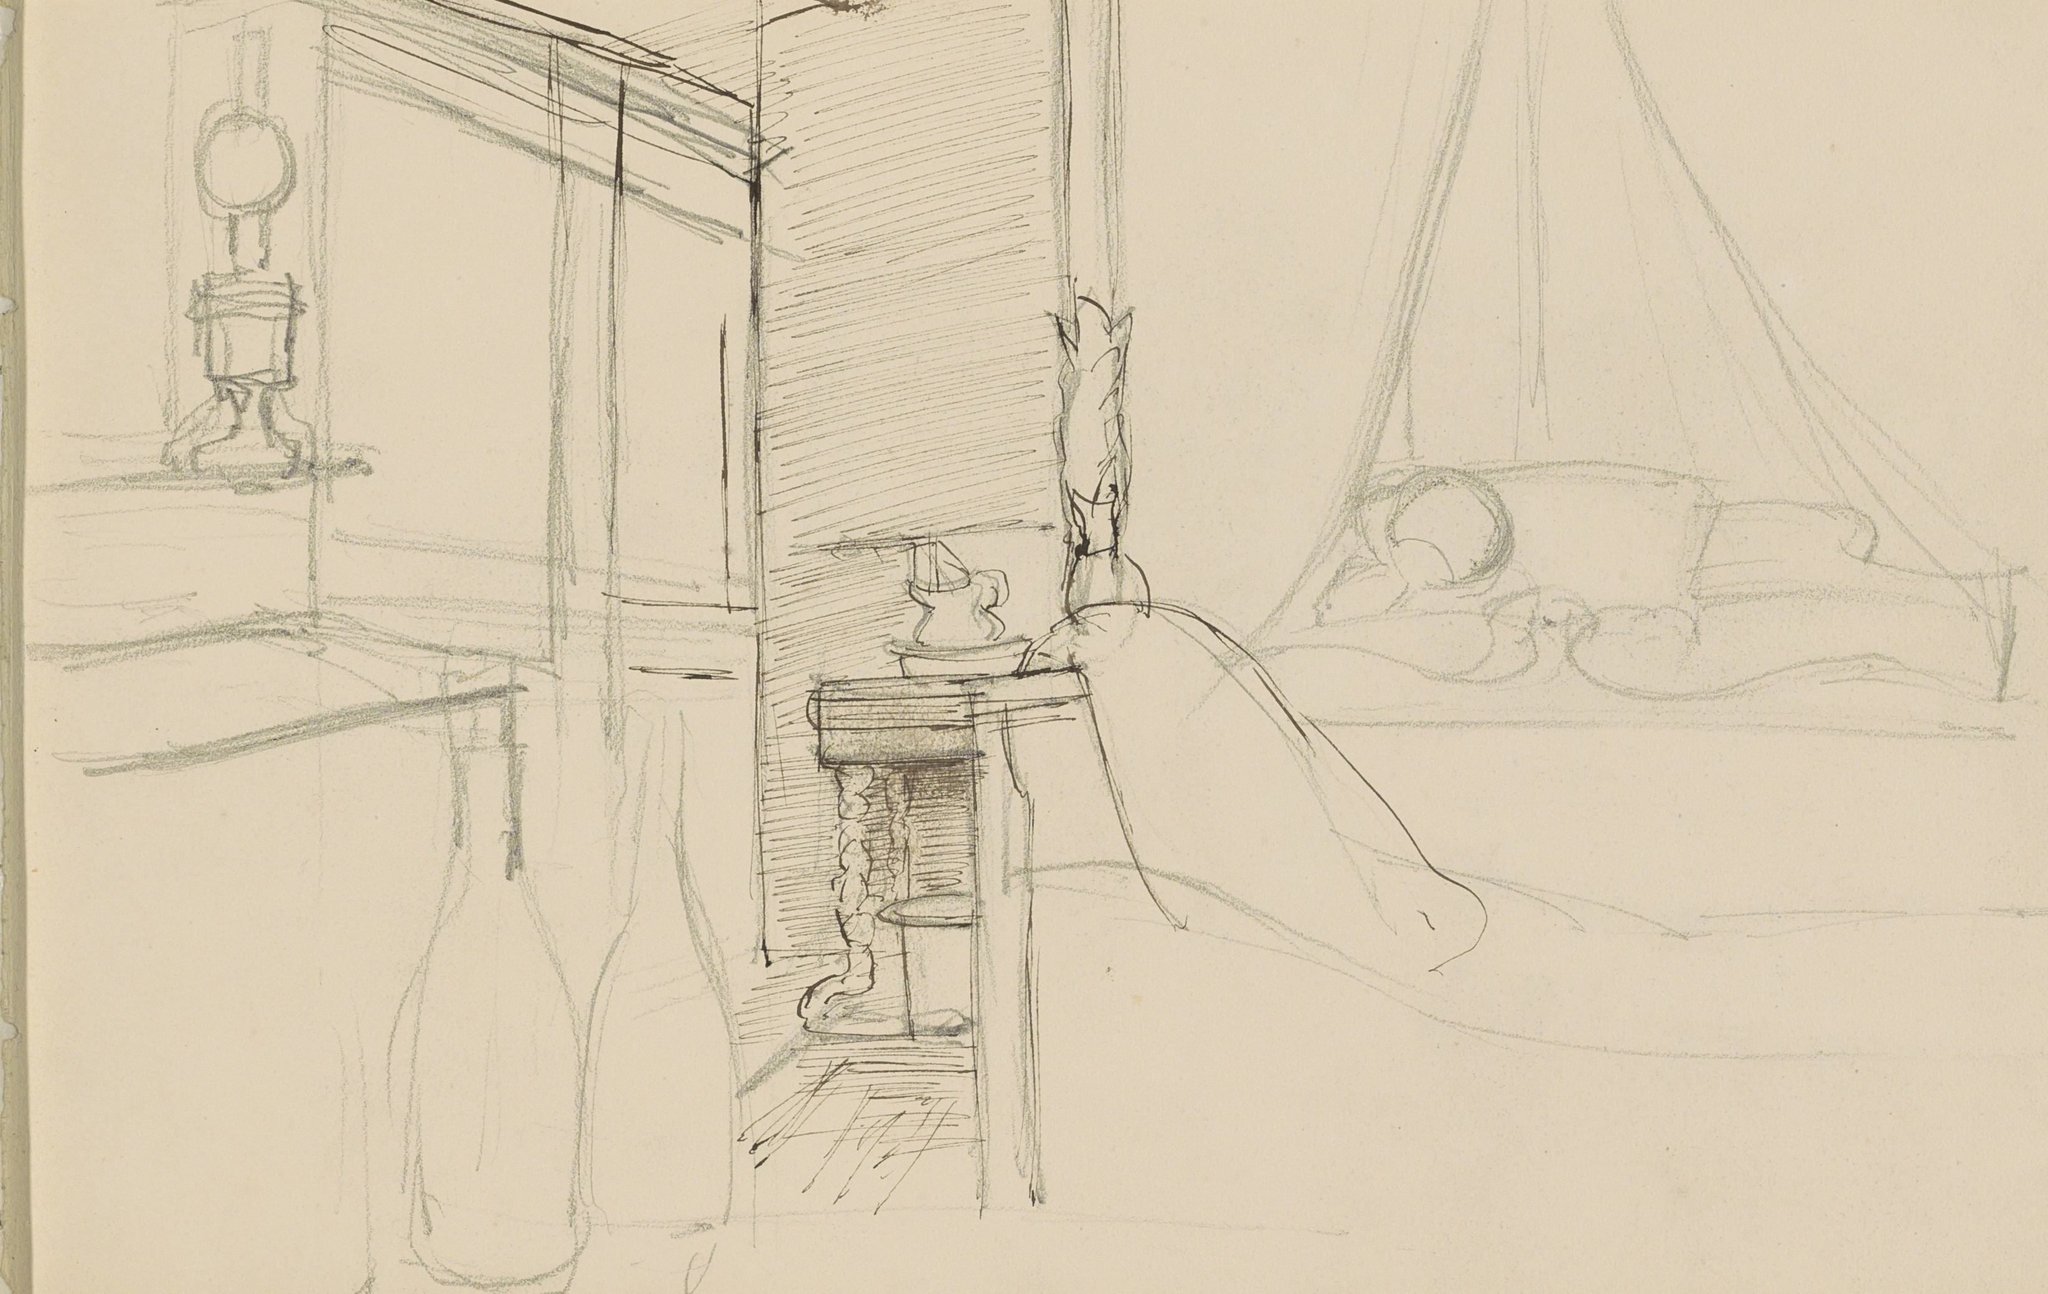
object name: sketchbook leaf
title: Interieur van een slaapkamer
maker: jozef israëls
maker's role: draughtsman, painter, print maker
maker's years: 1824-1911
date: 1834-1911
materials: ink, paper, pencil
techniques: pen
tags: bedroom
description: In het interieur staan een kast en nachtkastje. In het bed ligt vermoedelijk een figuur. Blad 6 recto uit een schetsboek met 25 bladen.